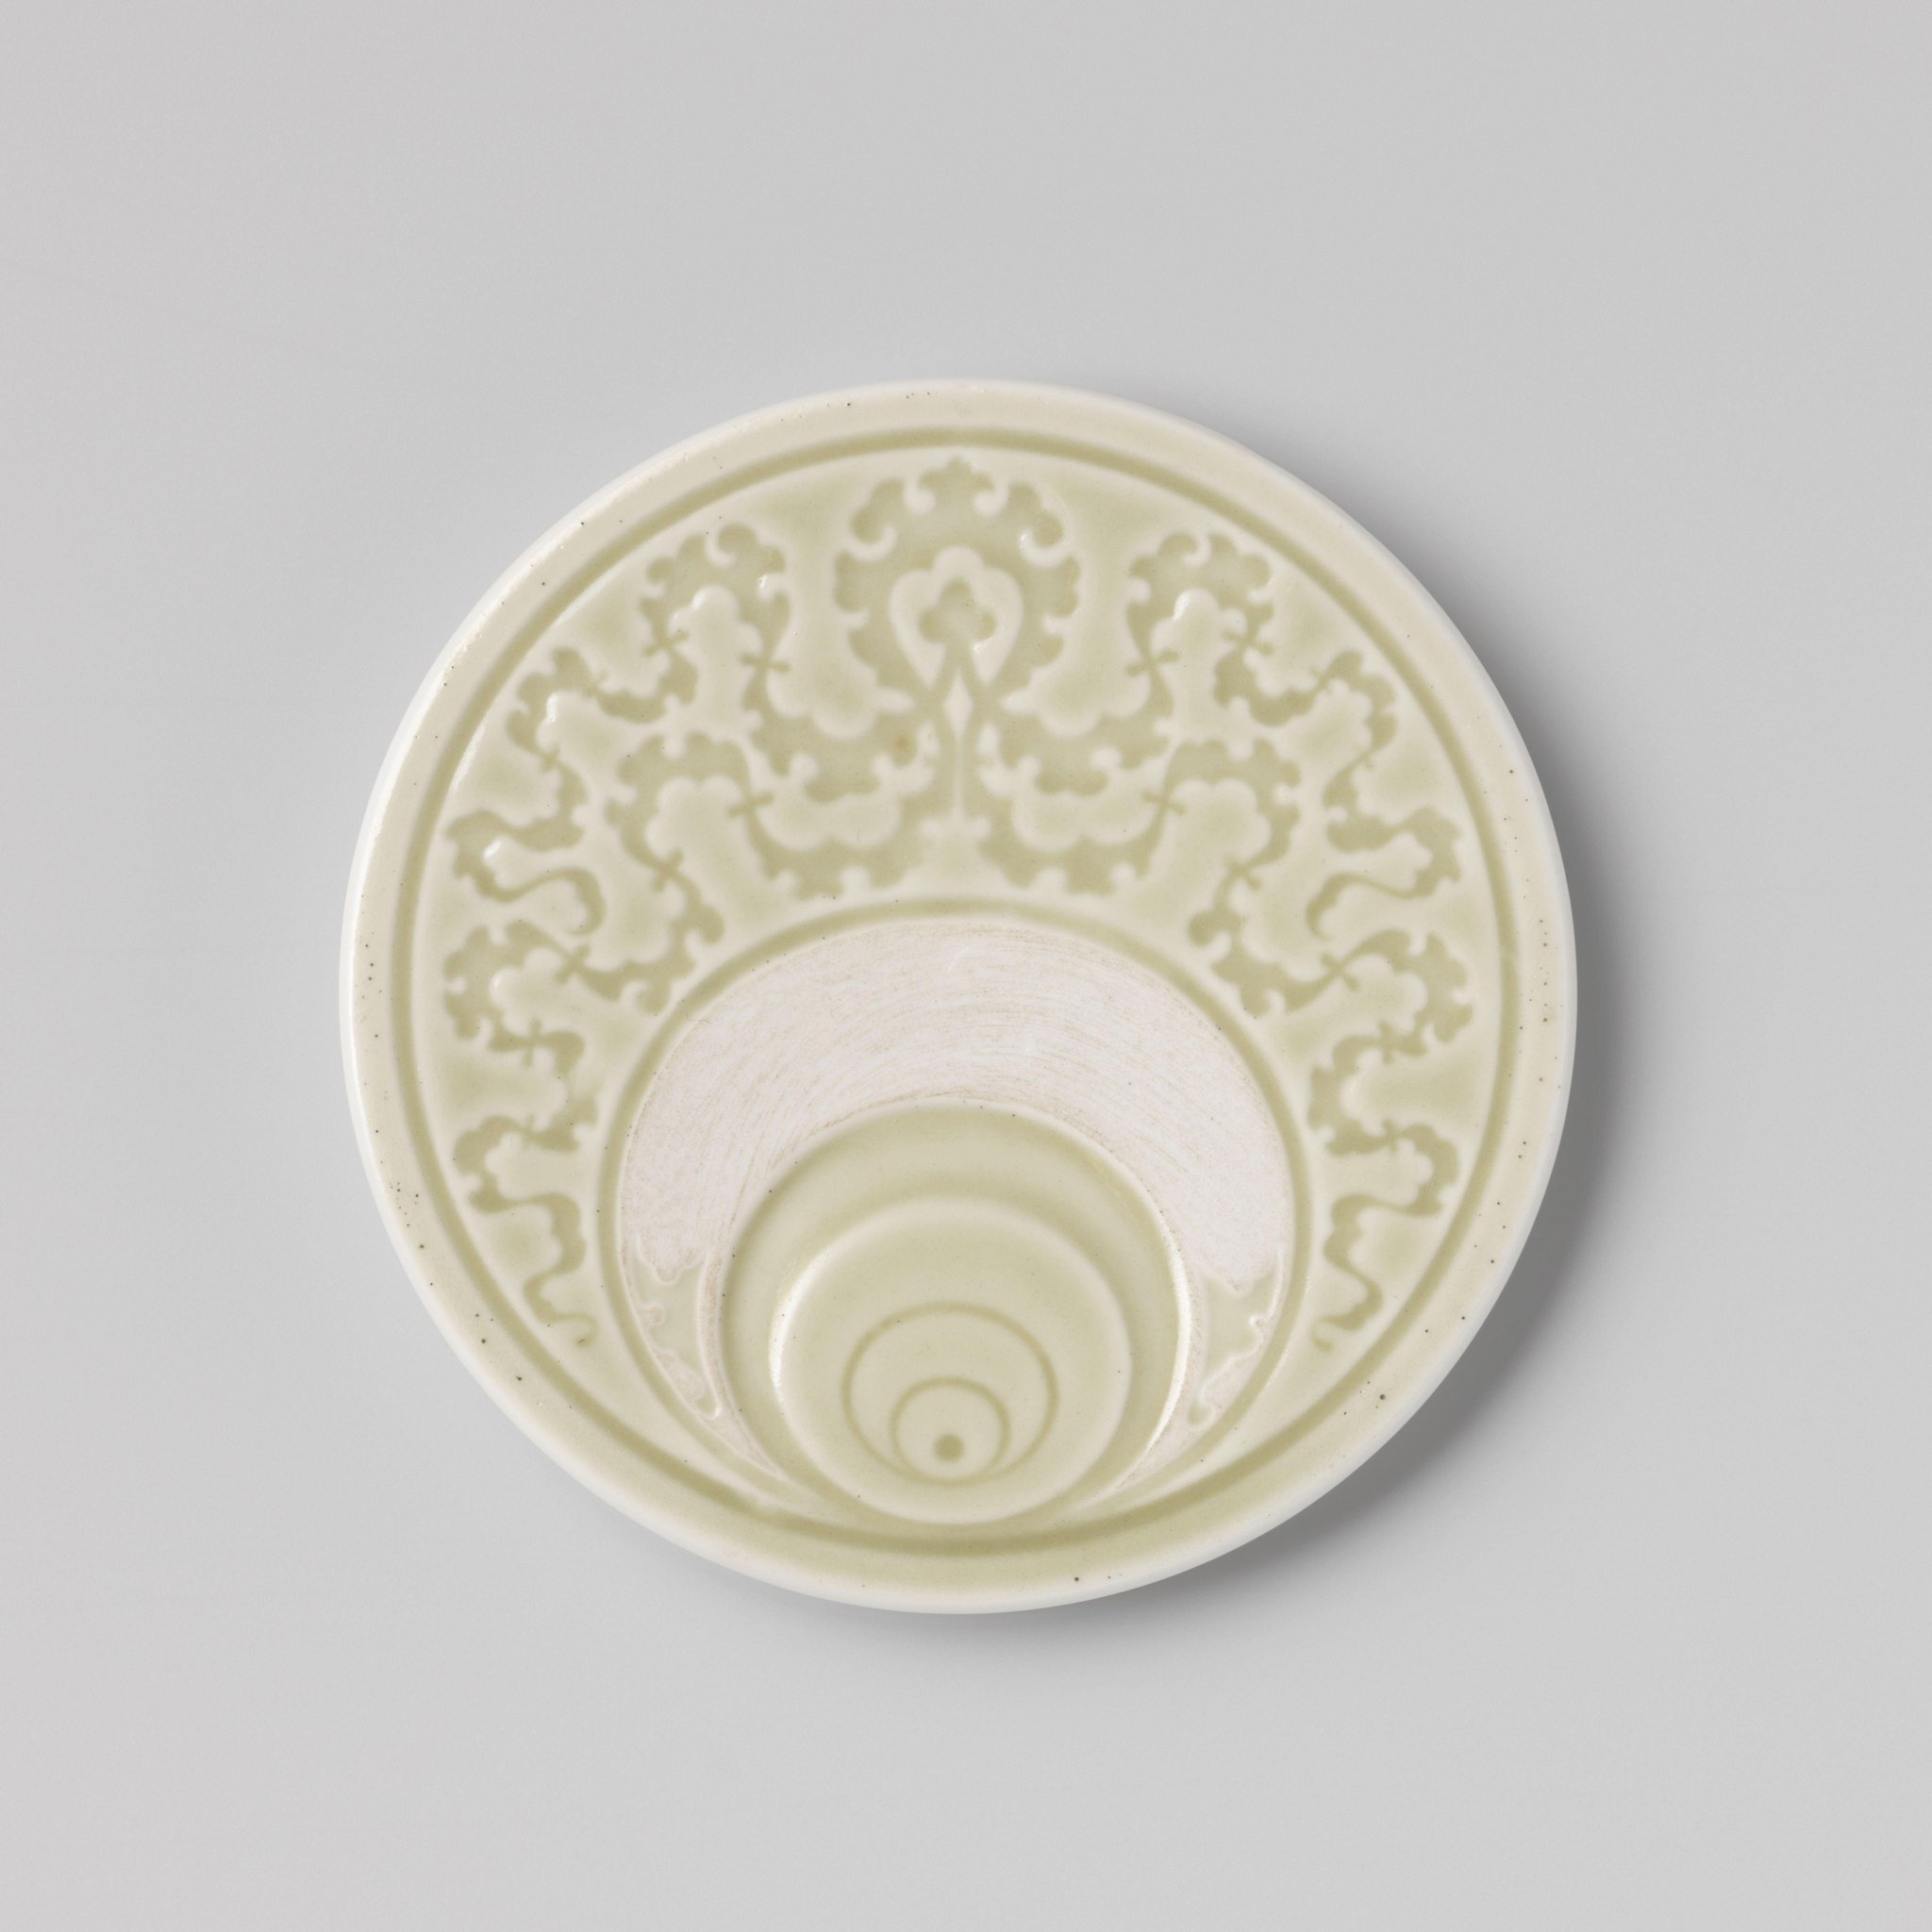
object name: plate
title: Round plate with scrolls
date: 1900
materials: glaze, paint, porcelain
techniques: firing, forming, vitrification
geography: berlin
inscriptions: mark: ‘scepter/ onleesbare cijfers/ M’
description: Ronde plaat (etiket?) van porselein op voetring. Op de voorzijde bedekt met een celadongroen glazuur, waarin uitgespaard een halfrond, ongeglazuurd schrijfvak. De voorzijde is verder versierd met gestempelde ranken. Gemerkt op de onderzijde met de scepter, onleesbare cijfers en de letter M. Art Nouveau.